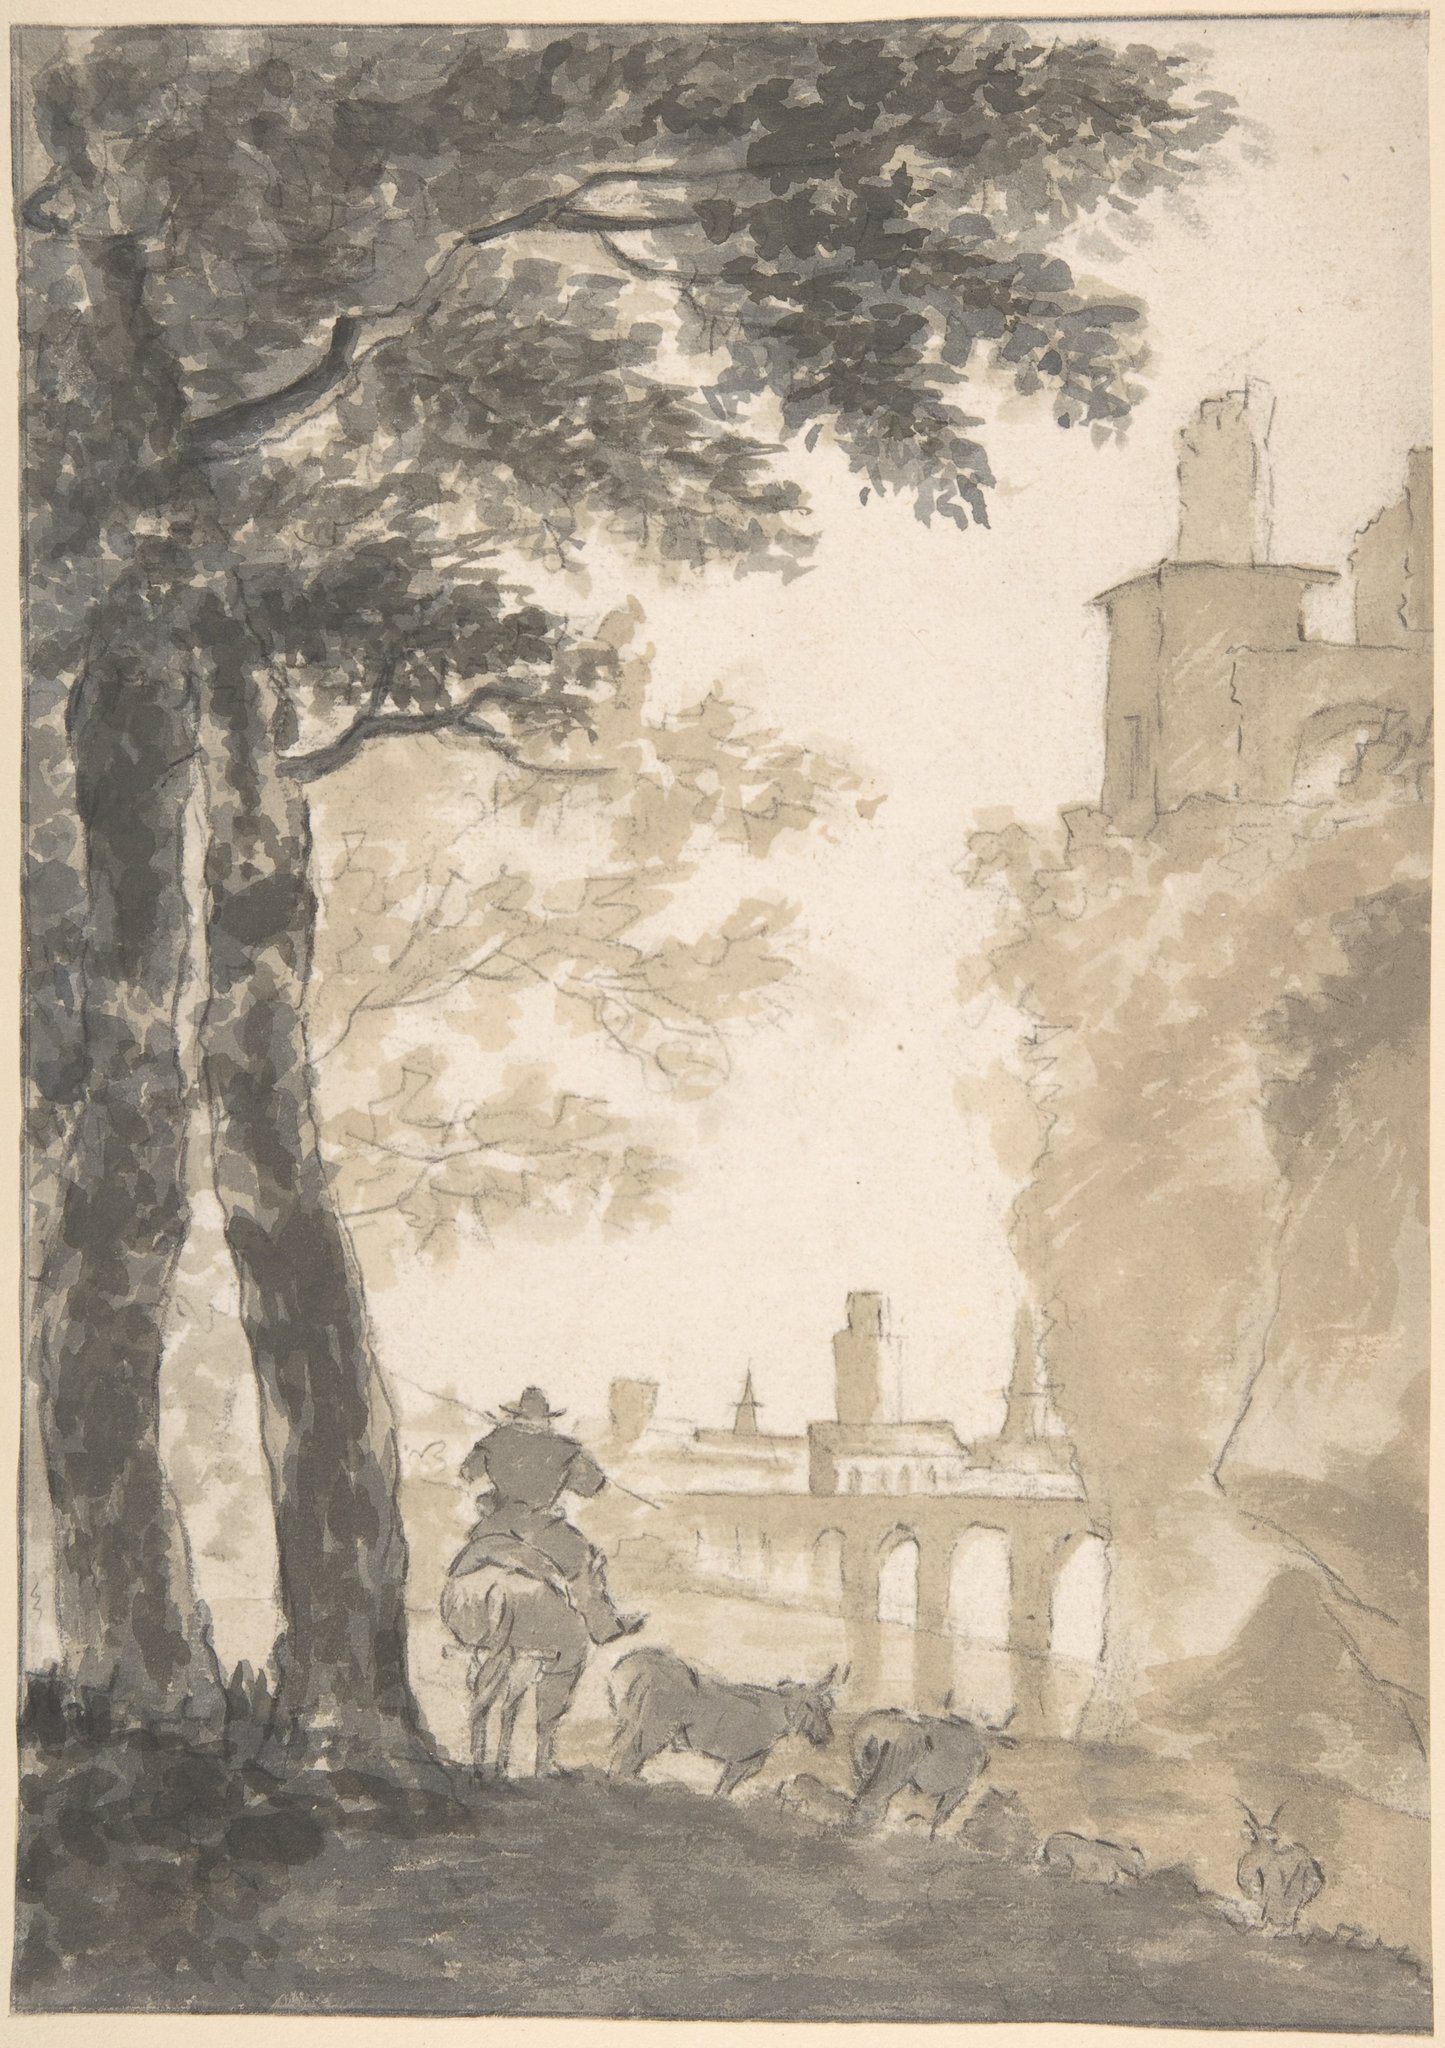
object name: drawing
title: Landscape with a Mounted Herdsman and Cows, a City in the Background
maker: jan both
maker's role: artist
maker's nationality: dutch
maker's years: 1618-1652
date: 1601-1700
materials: chalk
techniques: brush, wash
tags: cities,men,cows,landscapes,trees